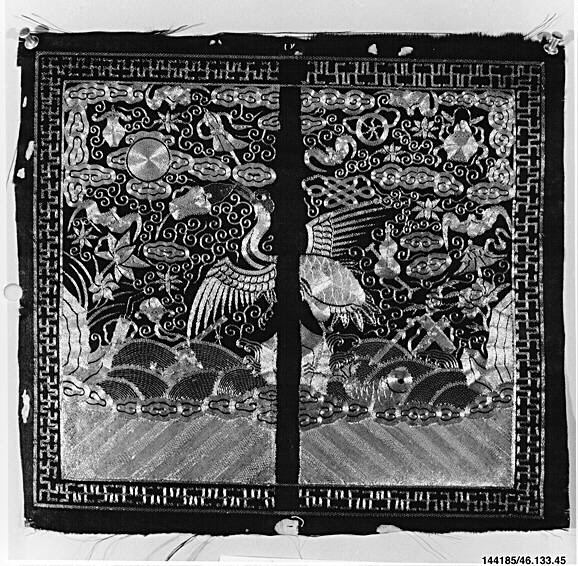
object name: rank badge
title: Rank Badge with Crane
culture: chinese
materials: gold, silk, silver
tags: bats,cranes,fish